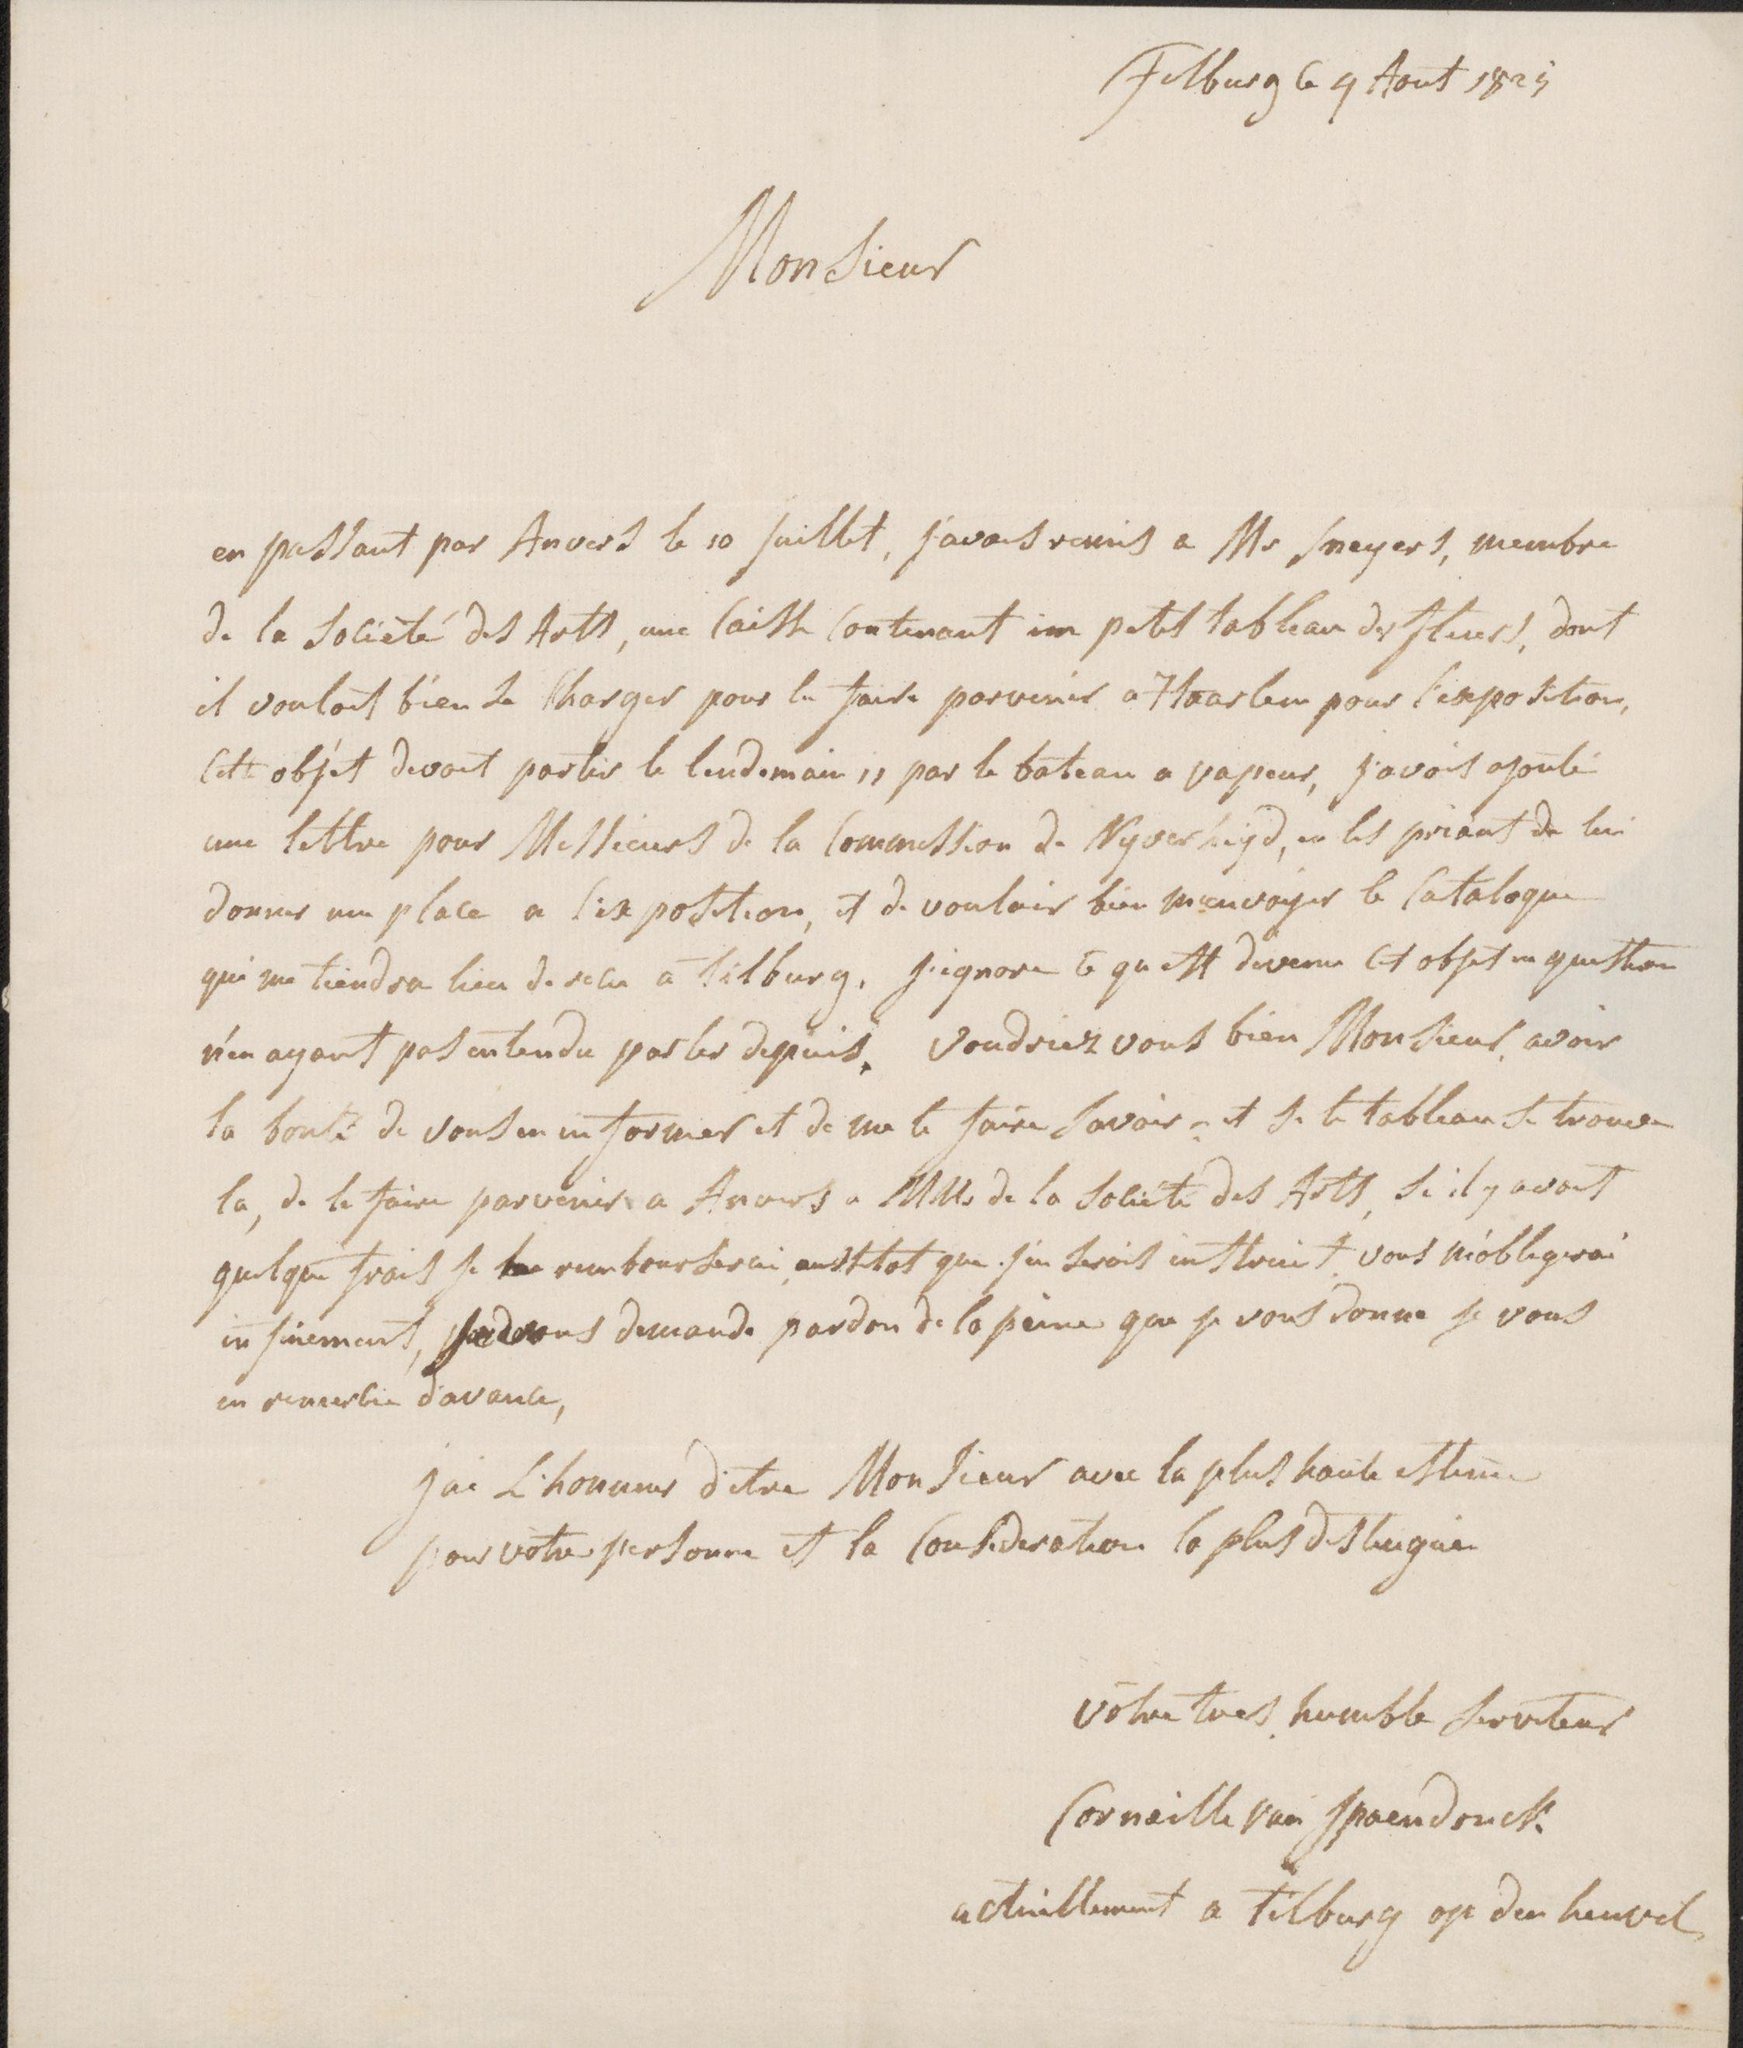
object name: letter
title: Brief aan Adriaan van der Willigen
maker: cornelis van spaendonck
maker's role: designer, draughtsman, painter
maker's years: 1756-1839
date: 1824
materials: ink, paper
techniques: pen, writing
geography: tilburg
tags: haarlem, adriaan van der willigen, painting (including book-illumination, miniature-painting), exhibition ~ art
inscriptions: watermark